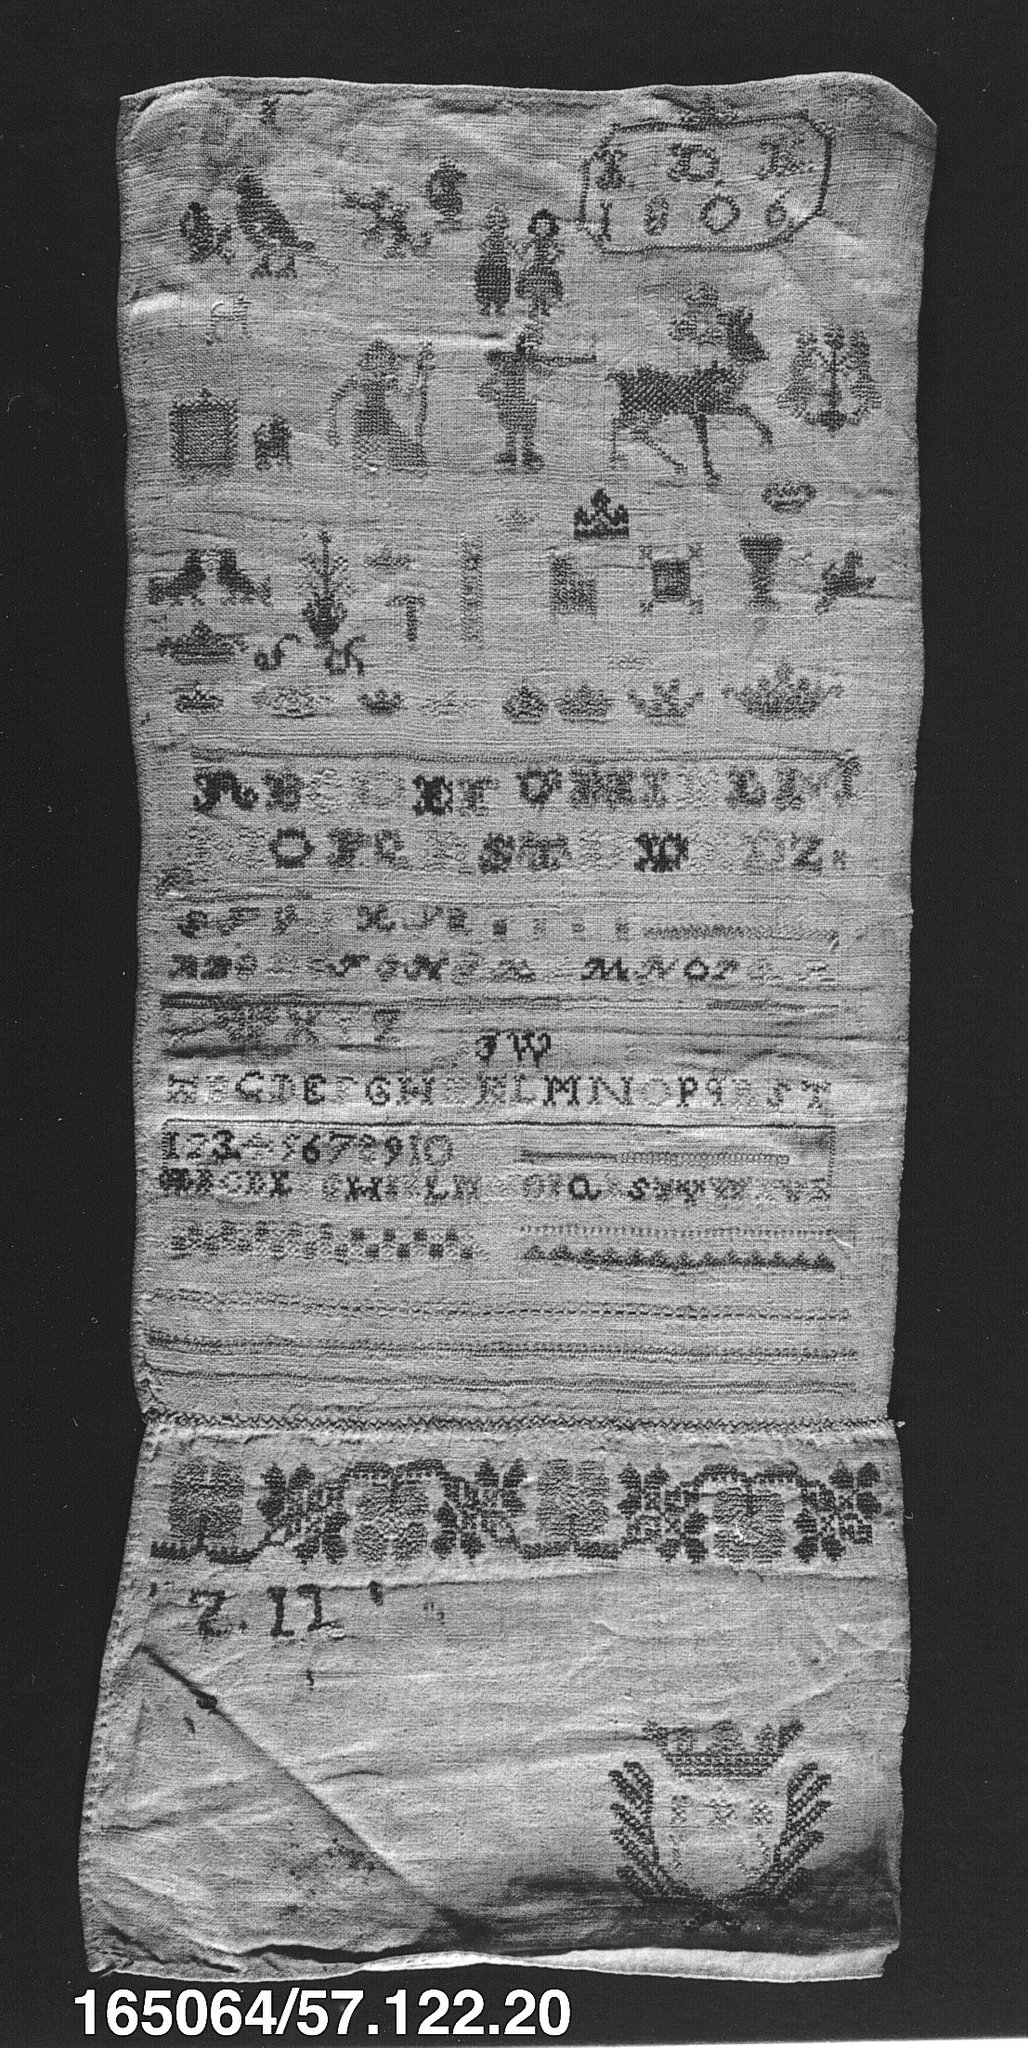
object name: sampler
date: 1806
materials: linen, silk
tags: human figures,birds,deer